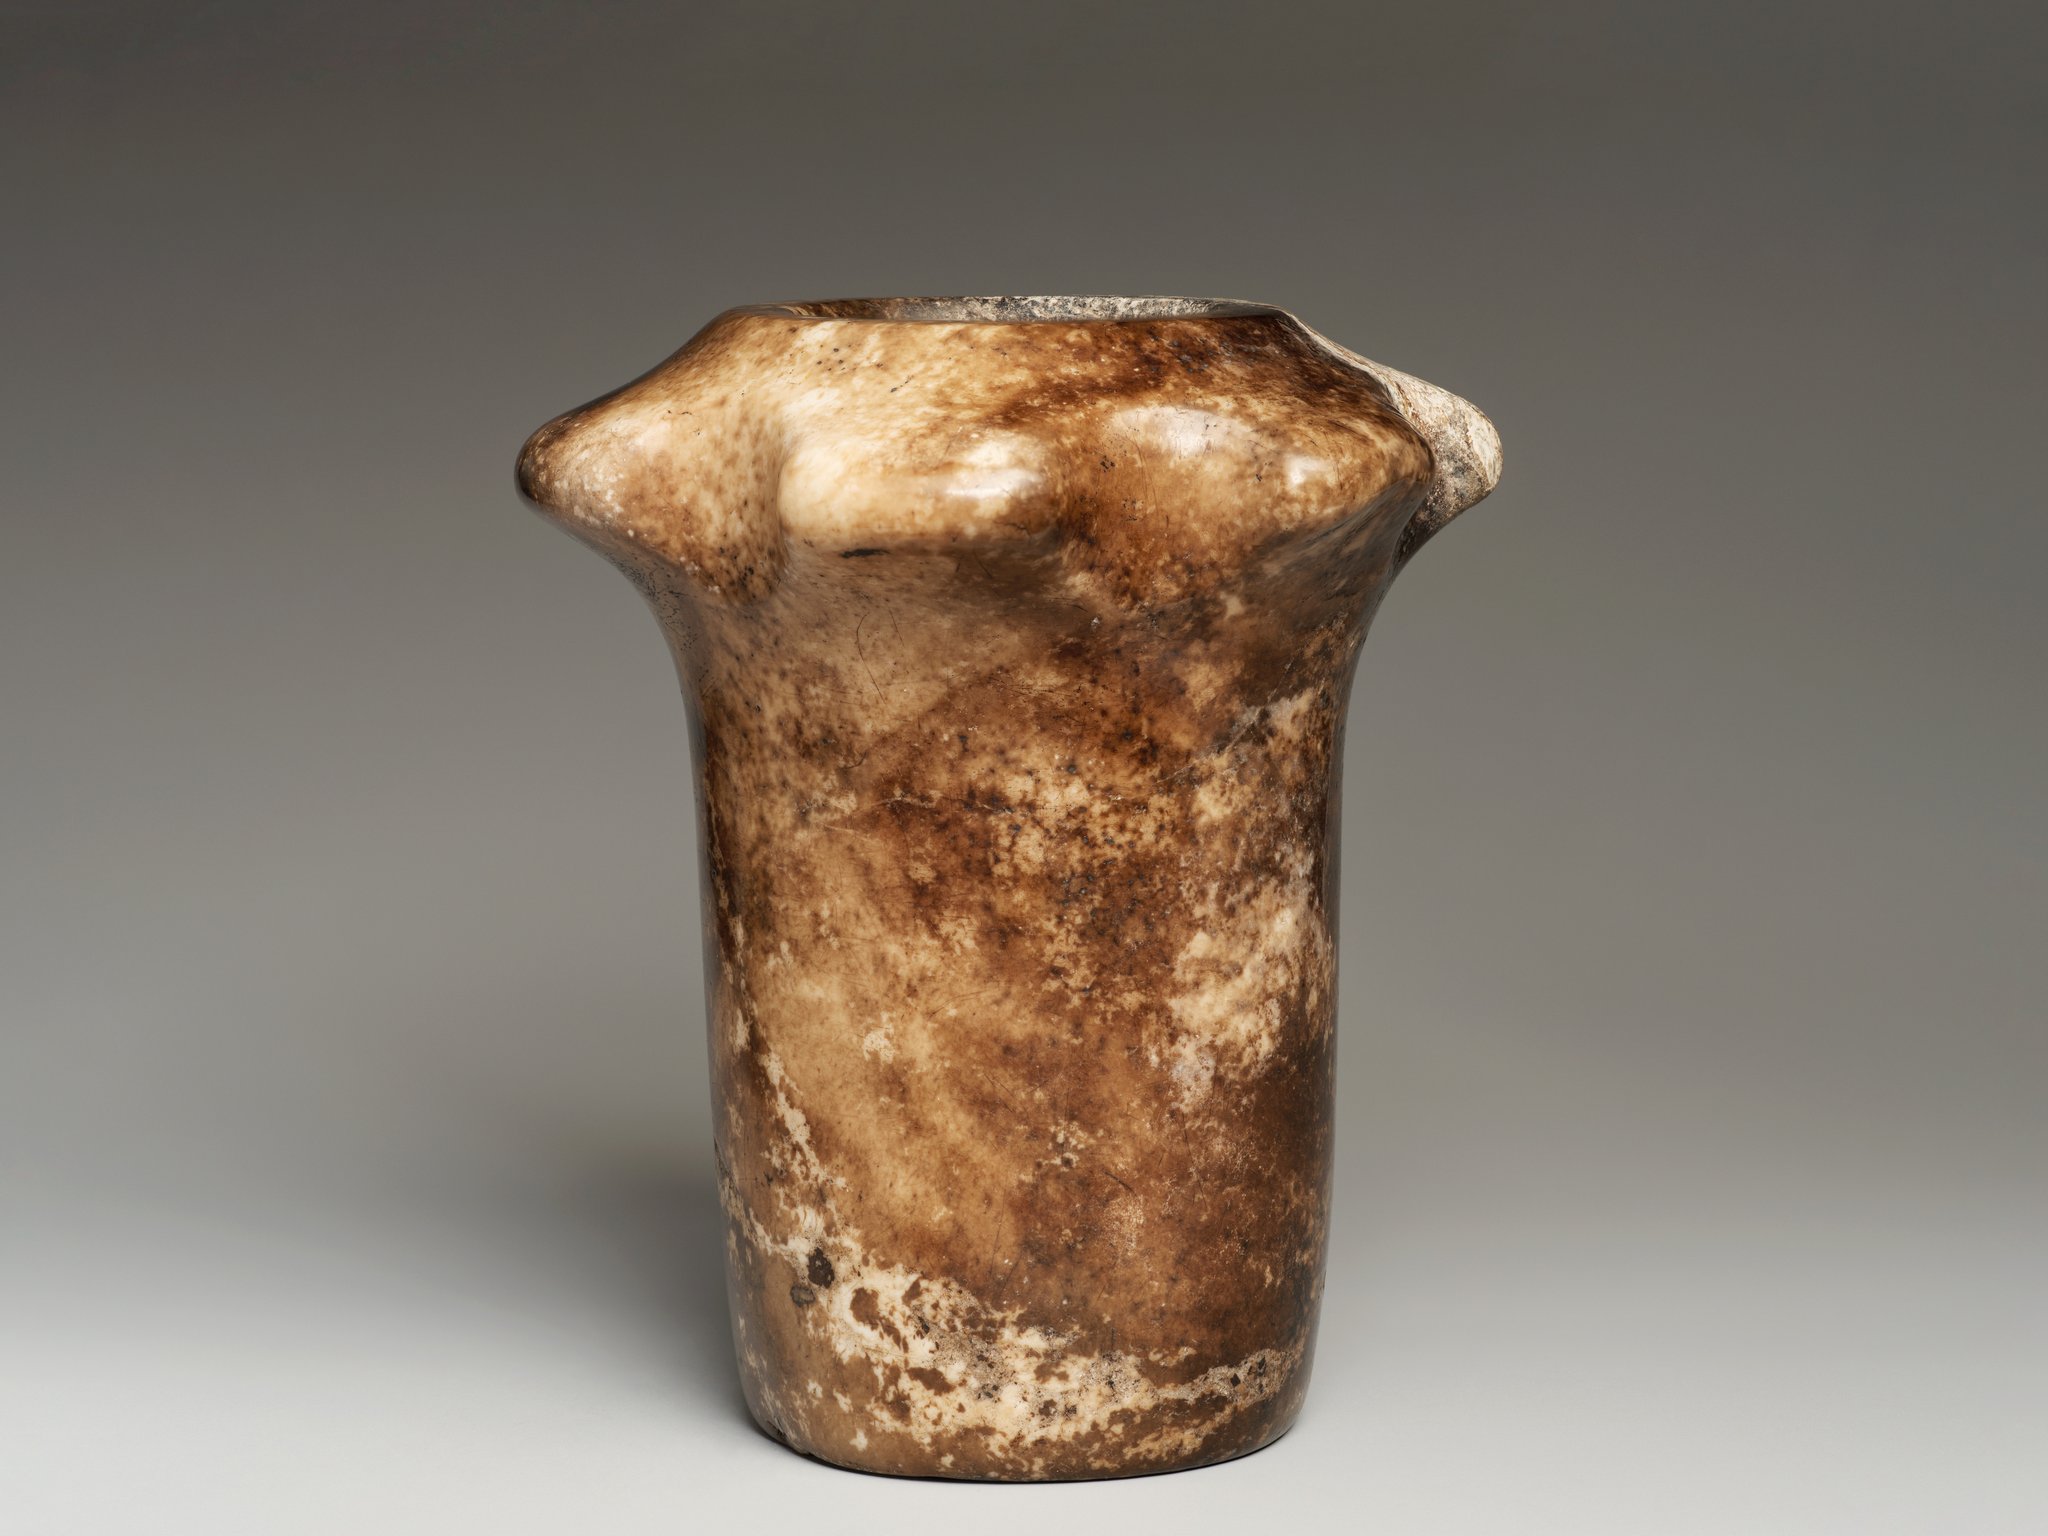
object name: mace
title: Mace head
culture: iranian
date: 900-801 BCE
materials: limestone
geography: iran